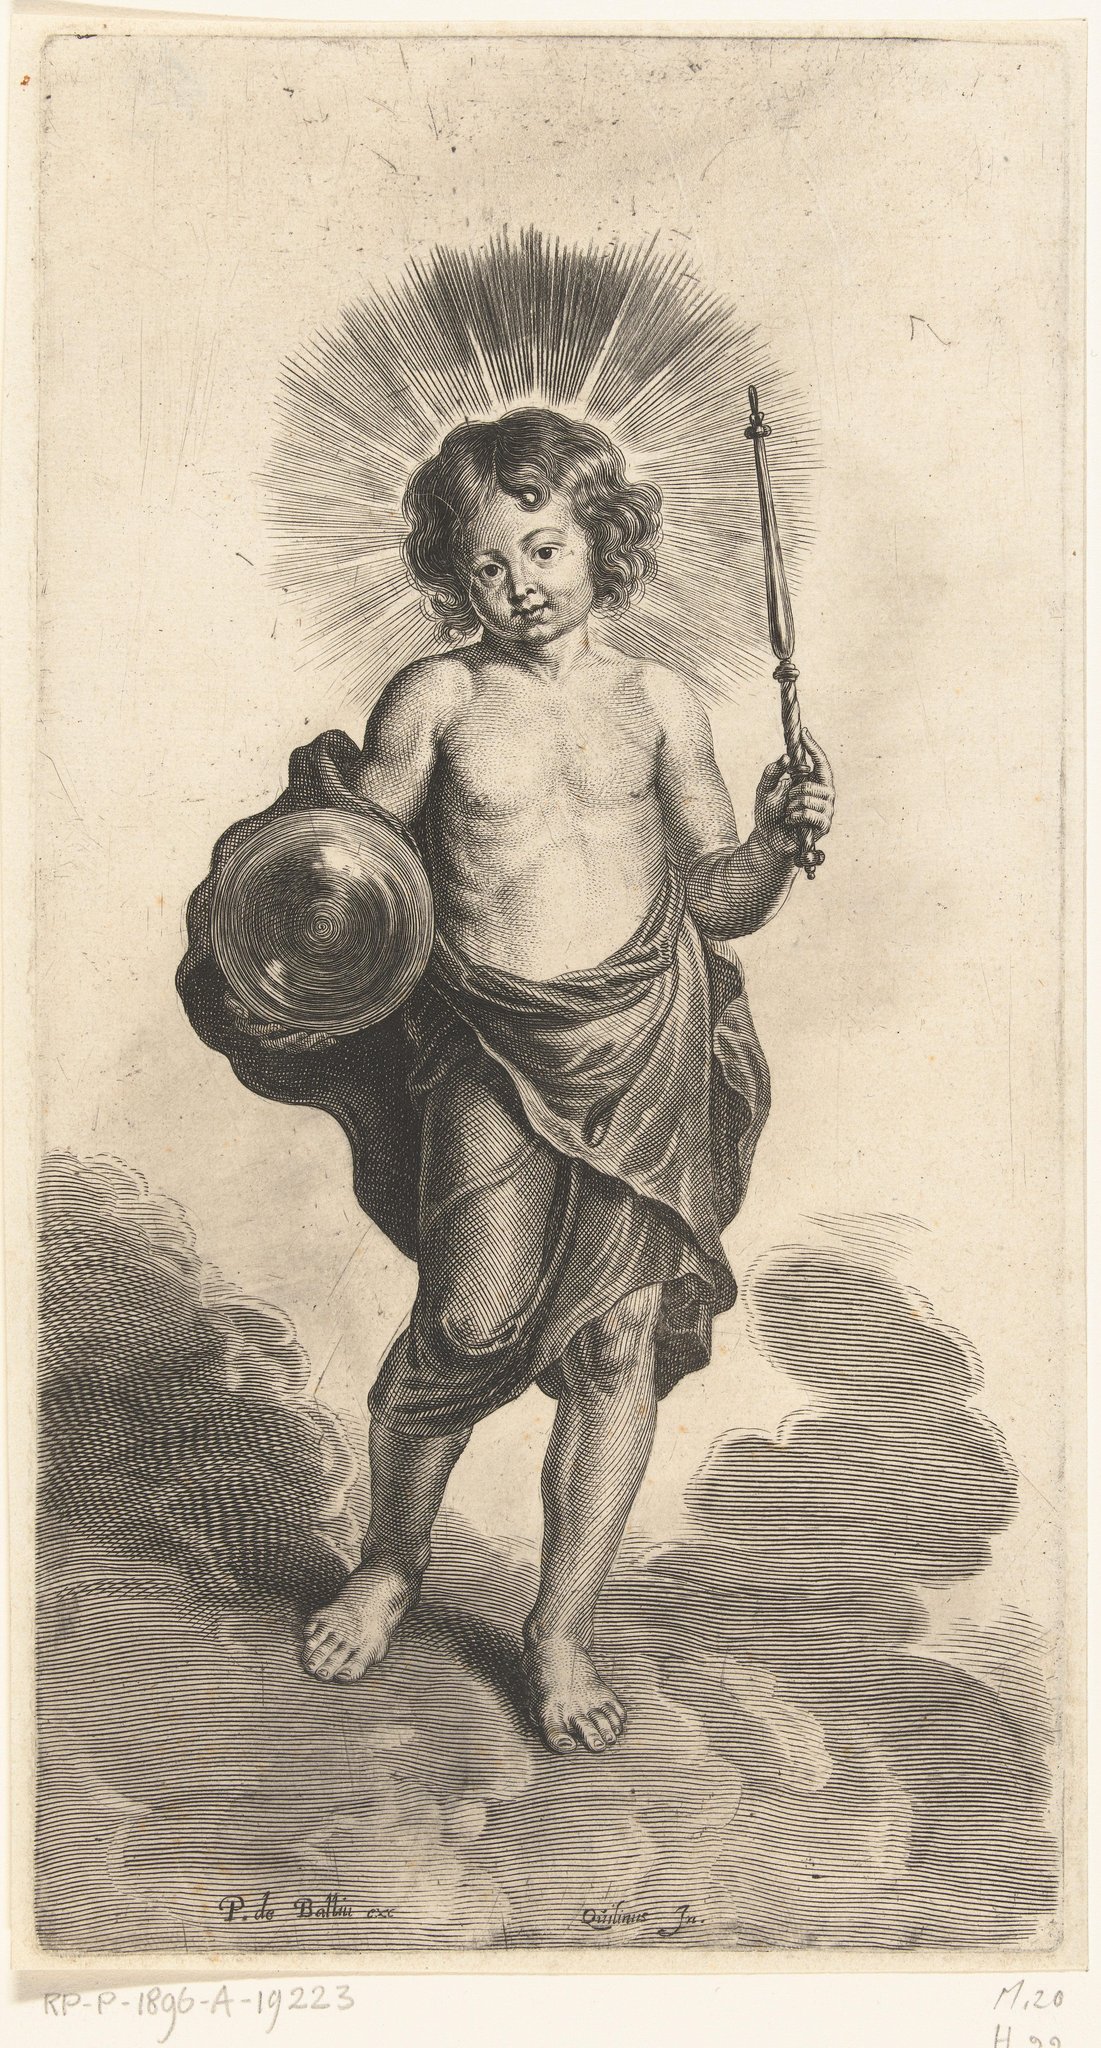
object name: print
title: Christuskind met globe en scepter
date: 1632-1660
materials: paper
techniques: engraving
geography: antwerp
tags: christ-child ~ types of adult christ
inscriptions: collector's mark: Lugt 2228